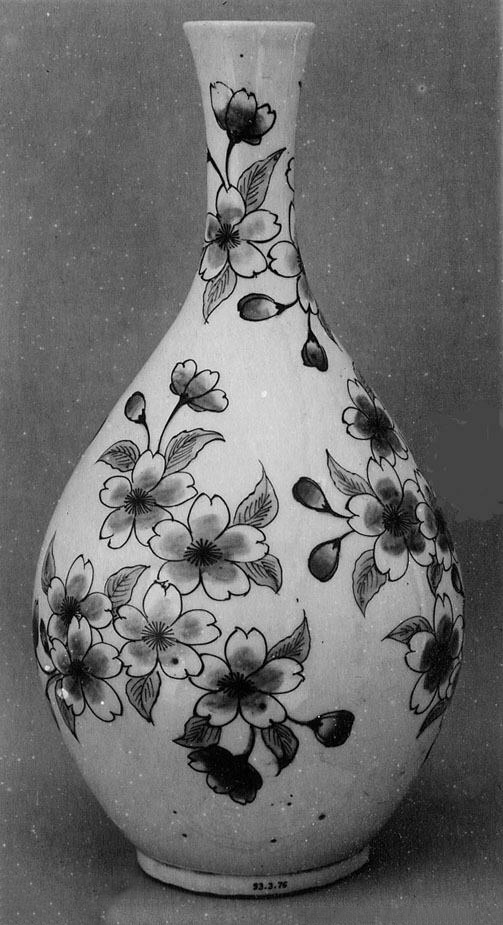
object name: wine bottle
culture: japanese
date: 1750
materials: enamel, glaze, porcelain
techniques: polychrome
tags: flowers